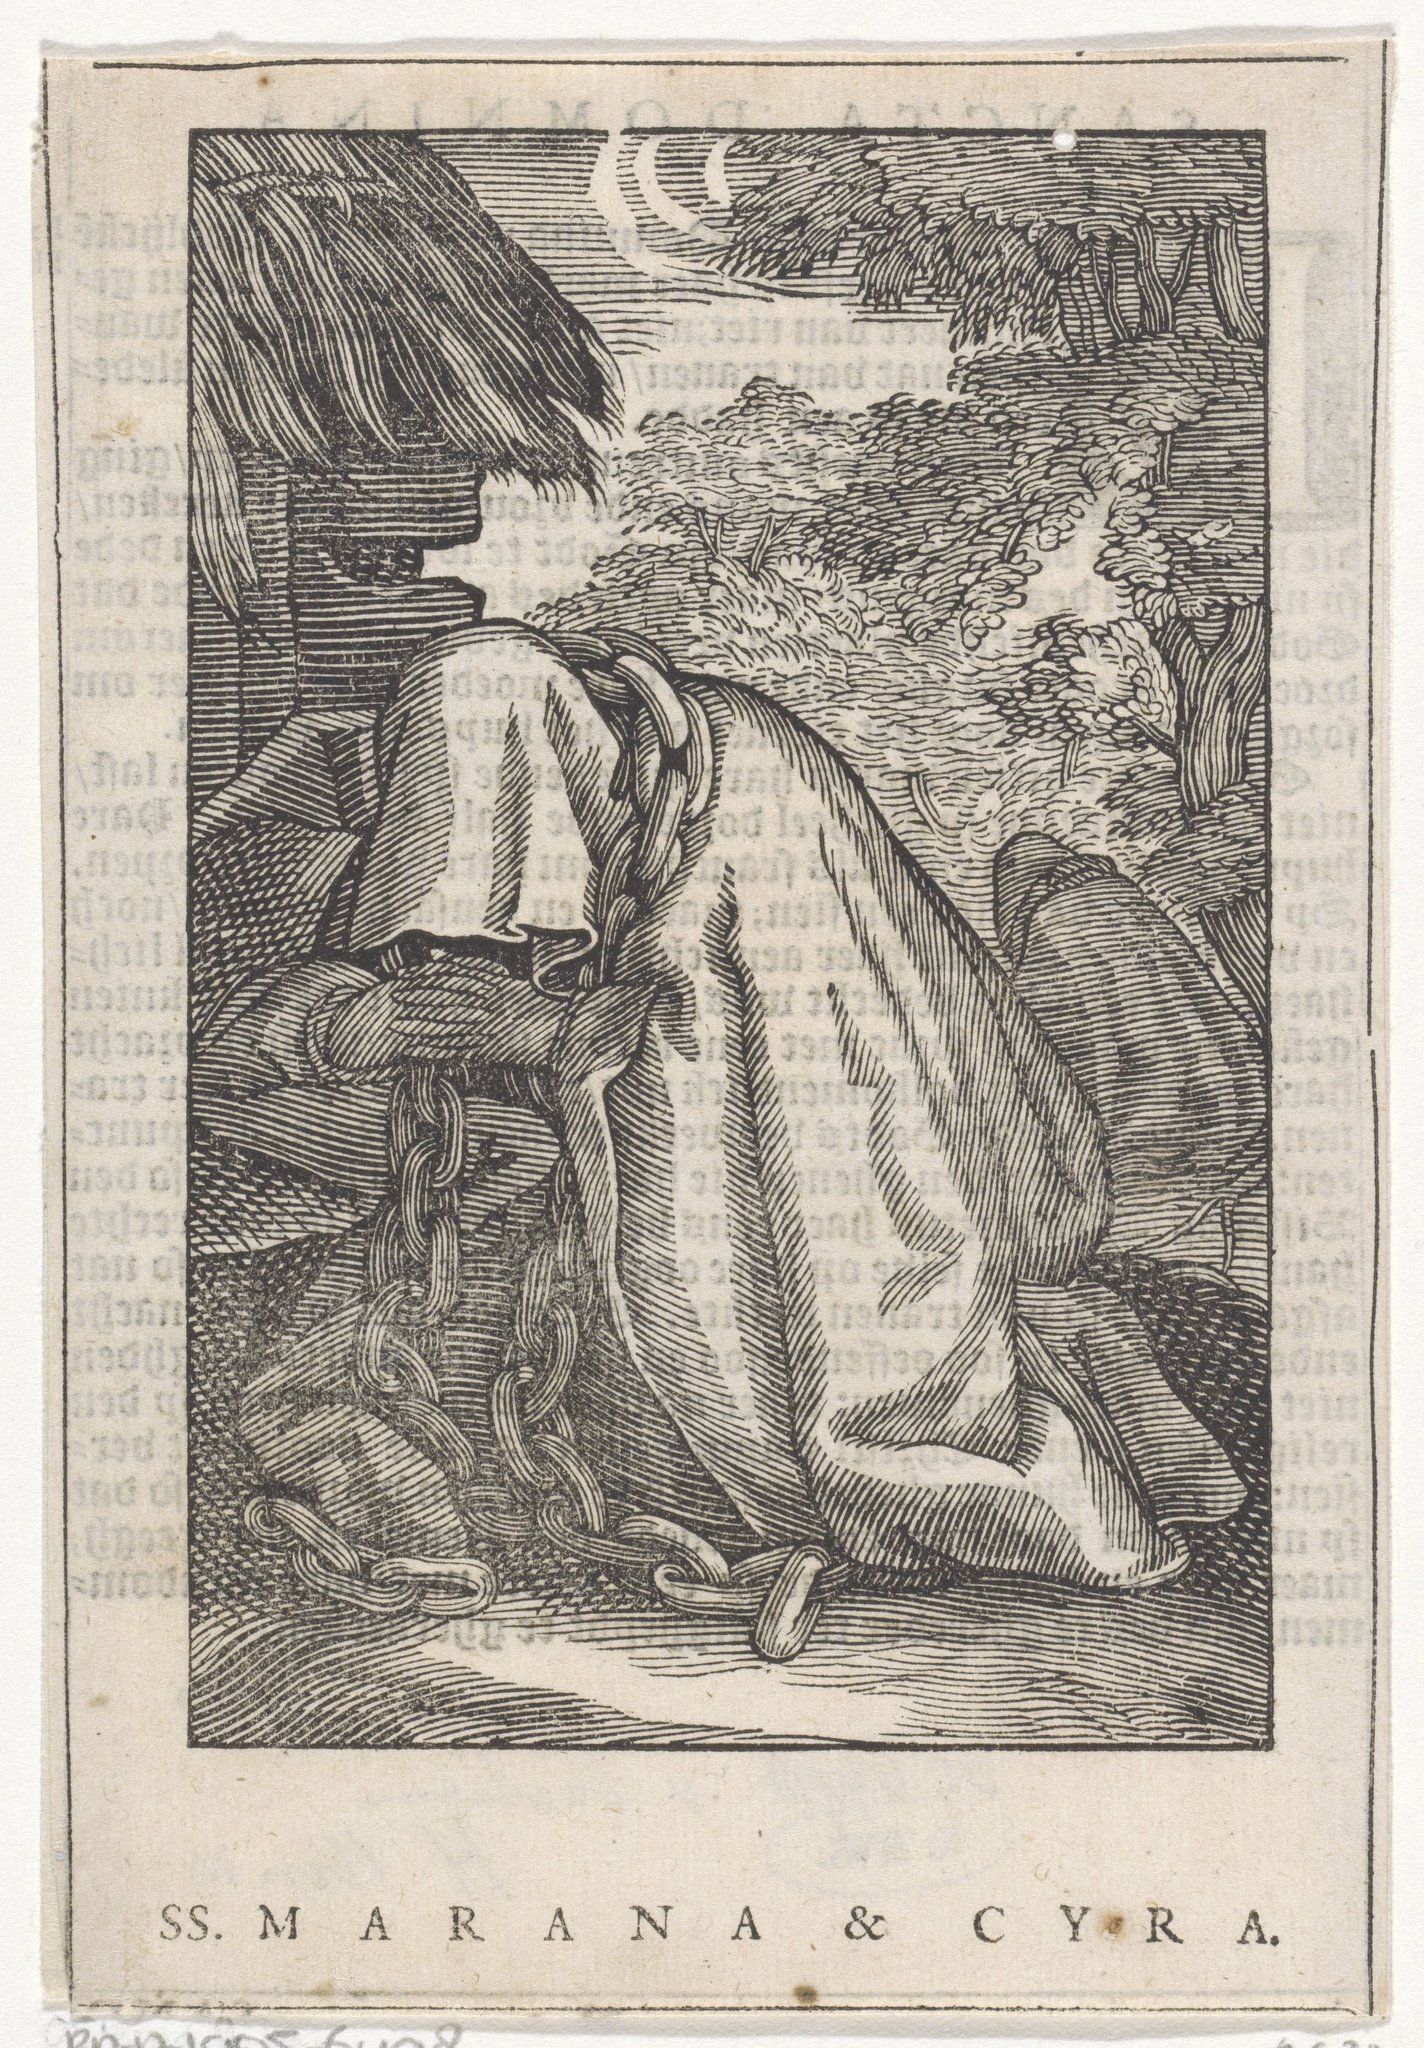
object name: book illustration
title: Heilige Marana van Syrië en heilige Cyra als kluizenaressen met ketenen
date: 1644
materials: paper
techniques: letterpress printing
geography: amsterdam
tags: anchorite, hermit, female saints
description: Prent uit: Rosweyde, Heribert. 'tBosch der eremyten ende eremitinnen, van Aegypten ende Palestinen. Amsterdam: Pieter Jacobsz. Paets, 1644.